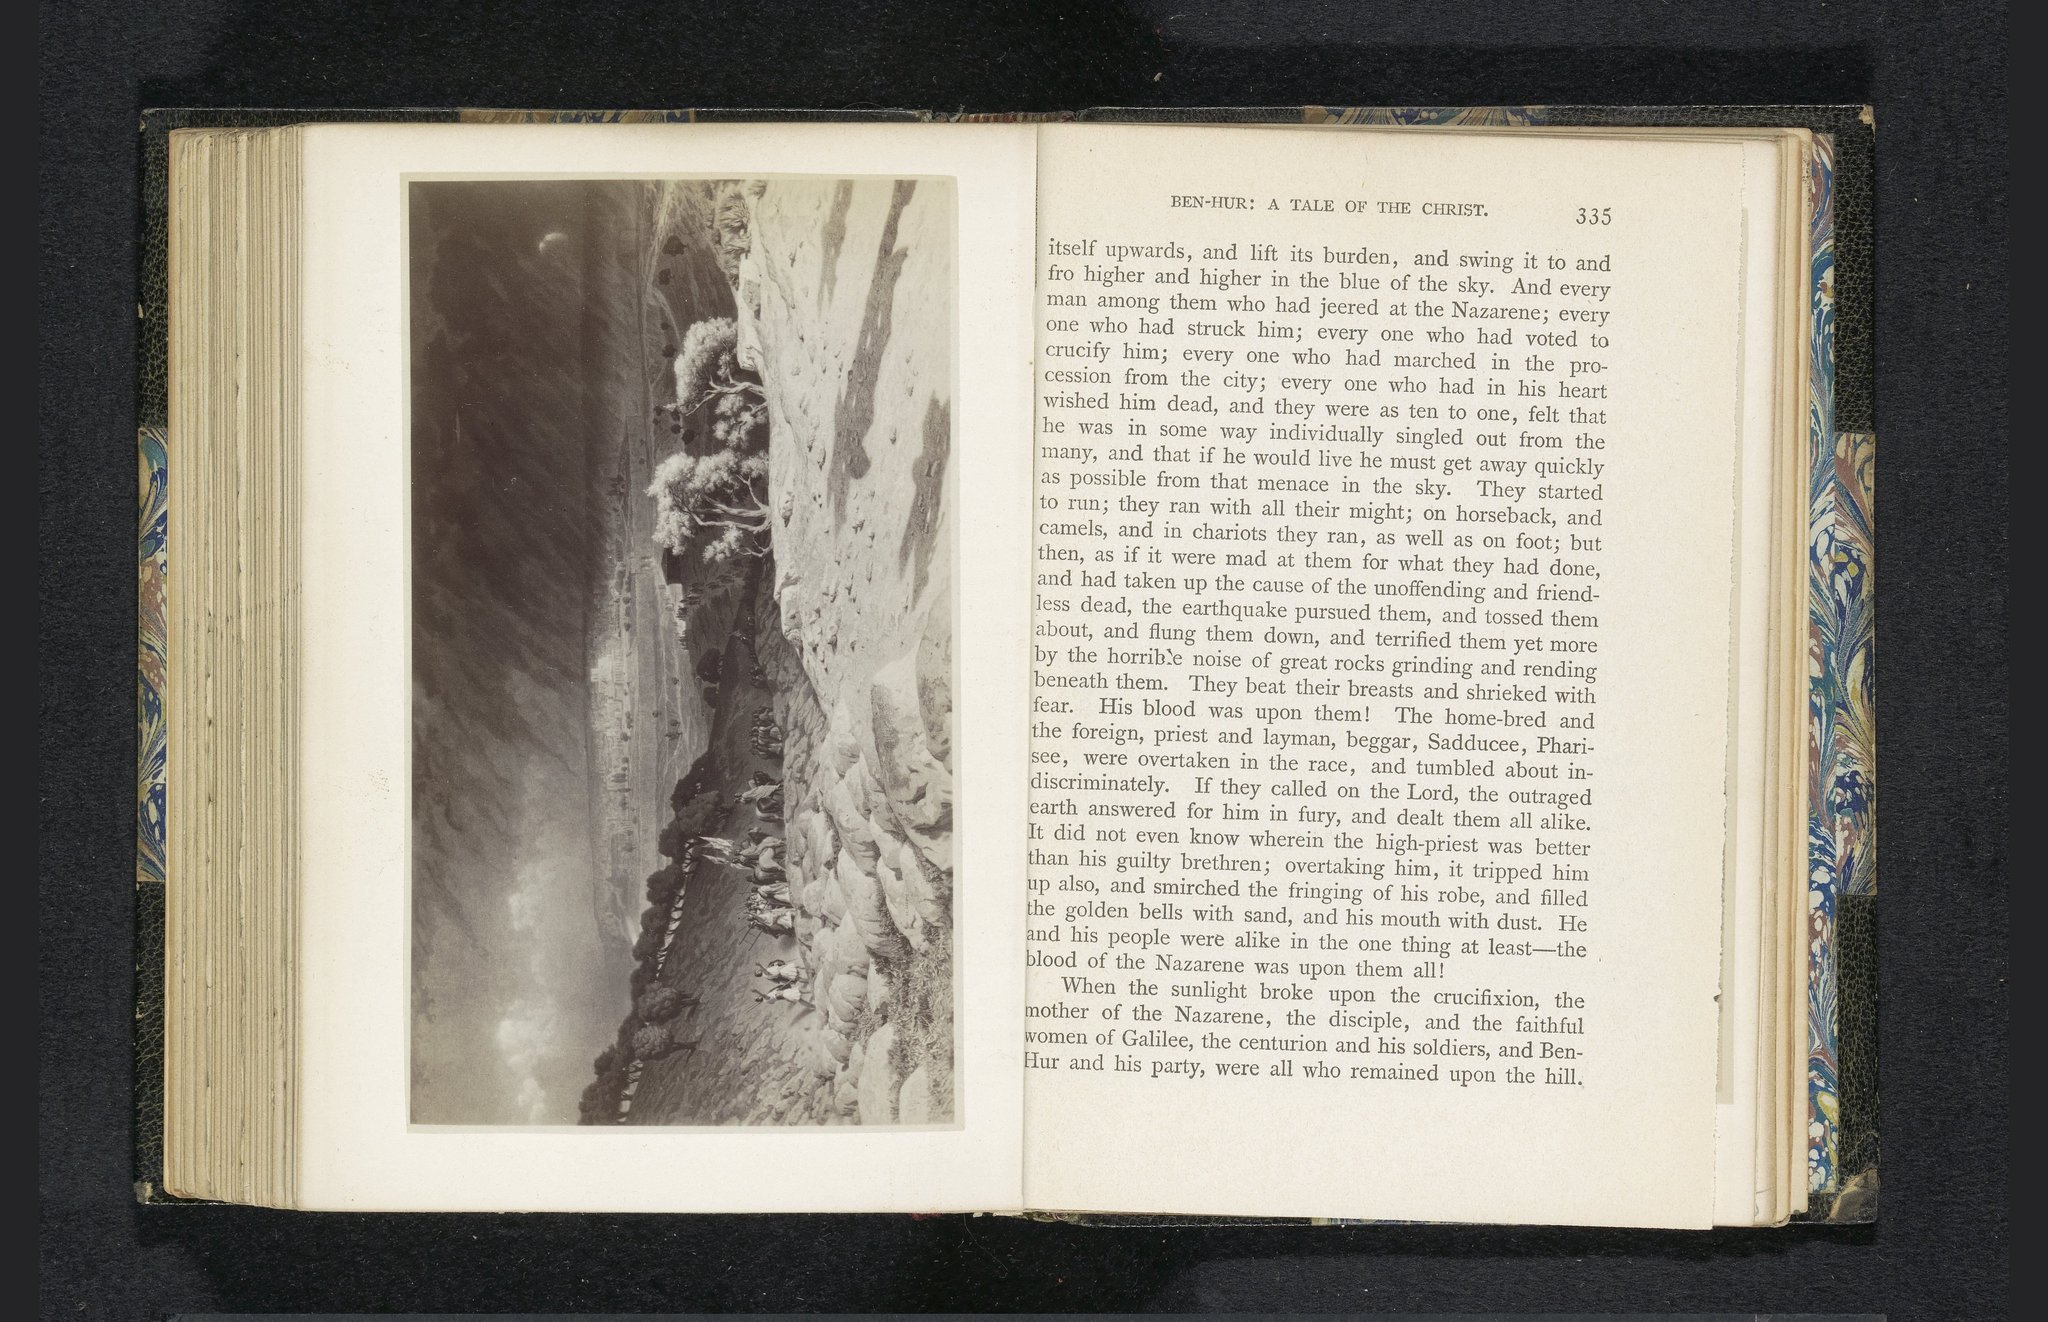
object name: page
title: Fotoreproductie van een schilderij, voorstellende een Romeins gezelschap vertrekt richting Jeruzalem na de kruisiging van Christus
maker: Anonymous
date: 1883-1888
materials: photographic support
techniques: albumen print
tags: the crucifixion of christ: christ's death on the cross; golgotha (matthew 27:45-58; mark 15:33-45; luke 23:44-52; john 19:25-38)